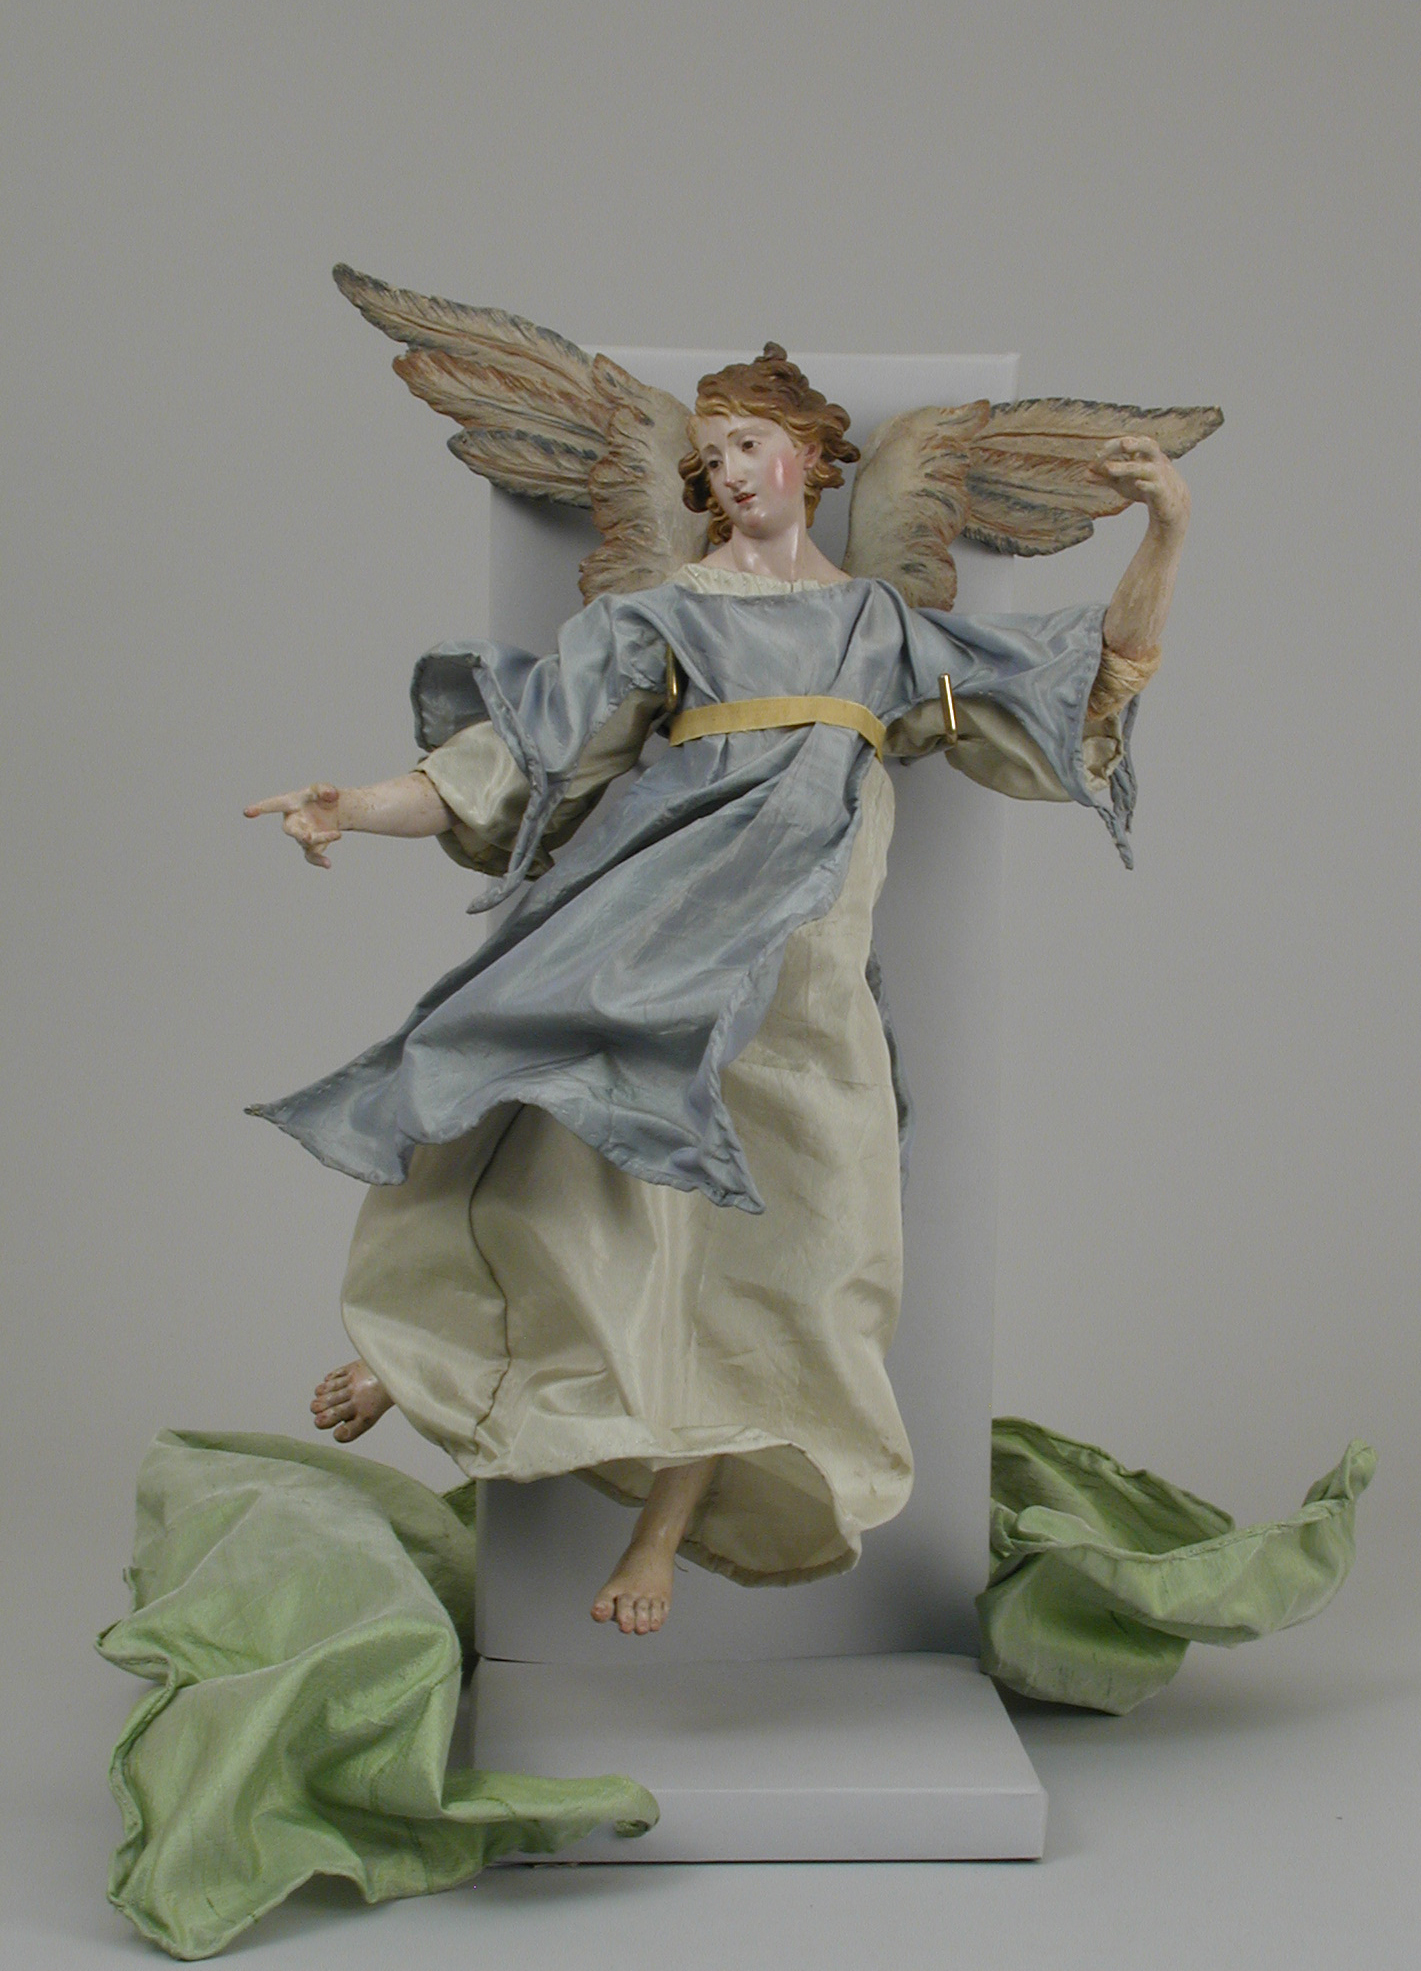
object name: crèche figure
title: Angel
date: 1767-1833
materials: textile, silk, fiber, terracotta, wood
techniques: polychrome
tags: angels